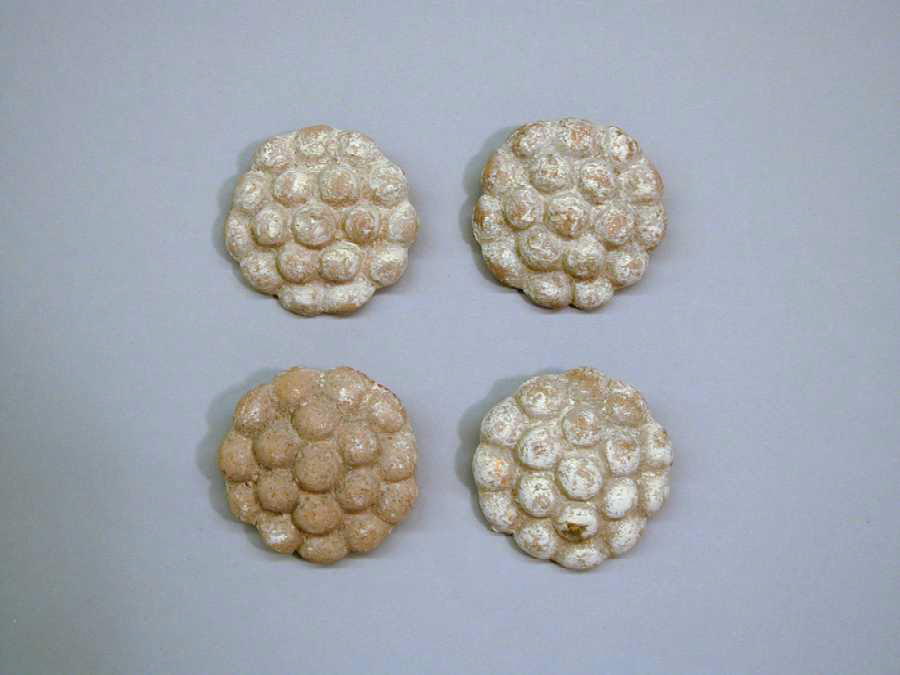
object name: disk of four rosette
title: Four terracotta disks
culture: greek or south italian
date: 300-168 BCE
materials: terracotta